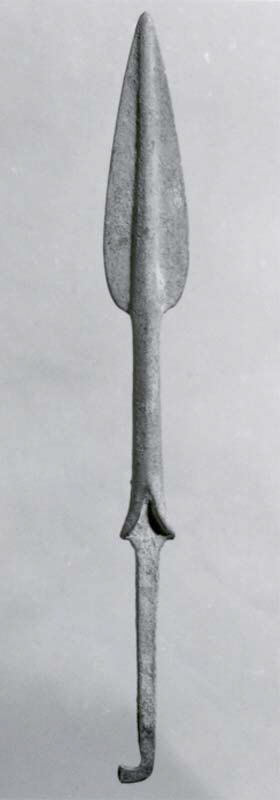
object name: spearhead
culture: iranian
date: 1333-668 BCE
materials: bronze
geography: northwestern iran, caspian region